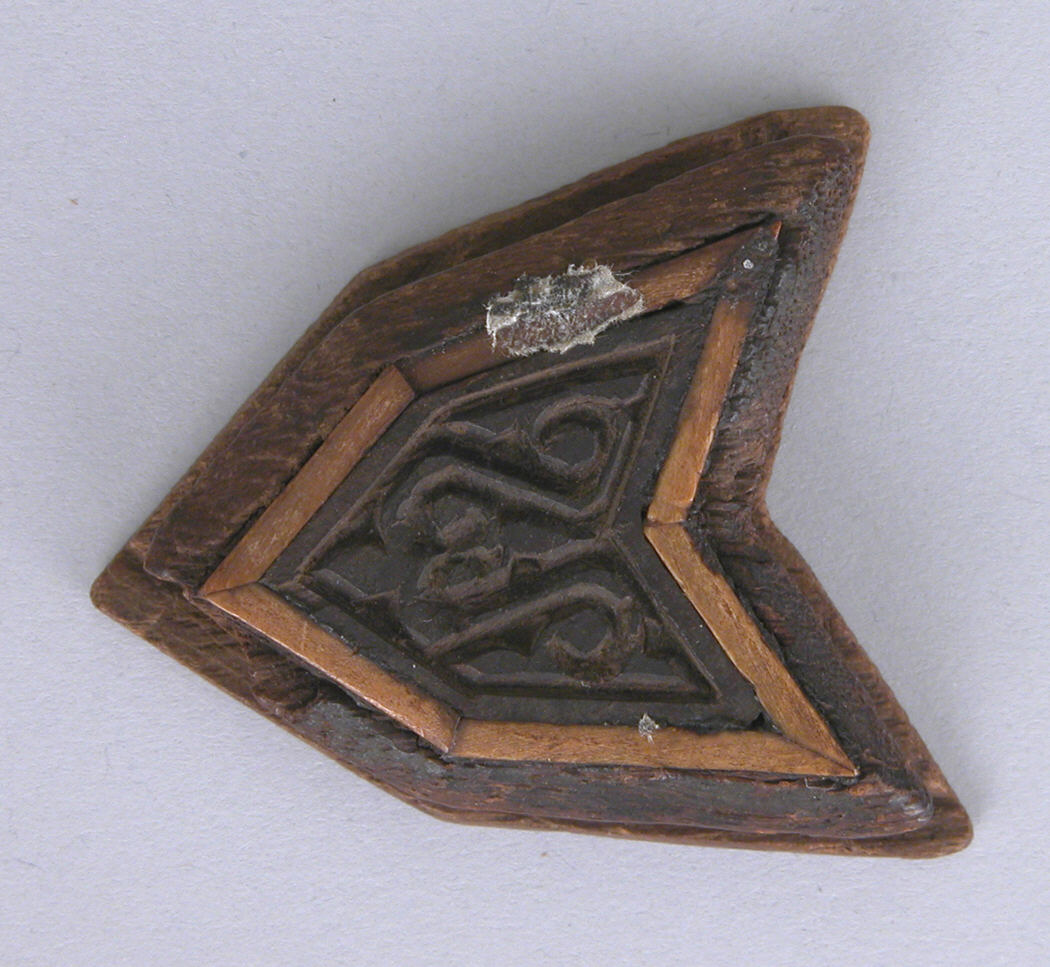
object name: panel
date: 1301-1500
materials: ivory, wood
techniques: carving, inlay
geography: egypt